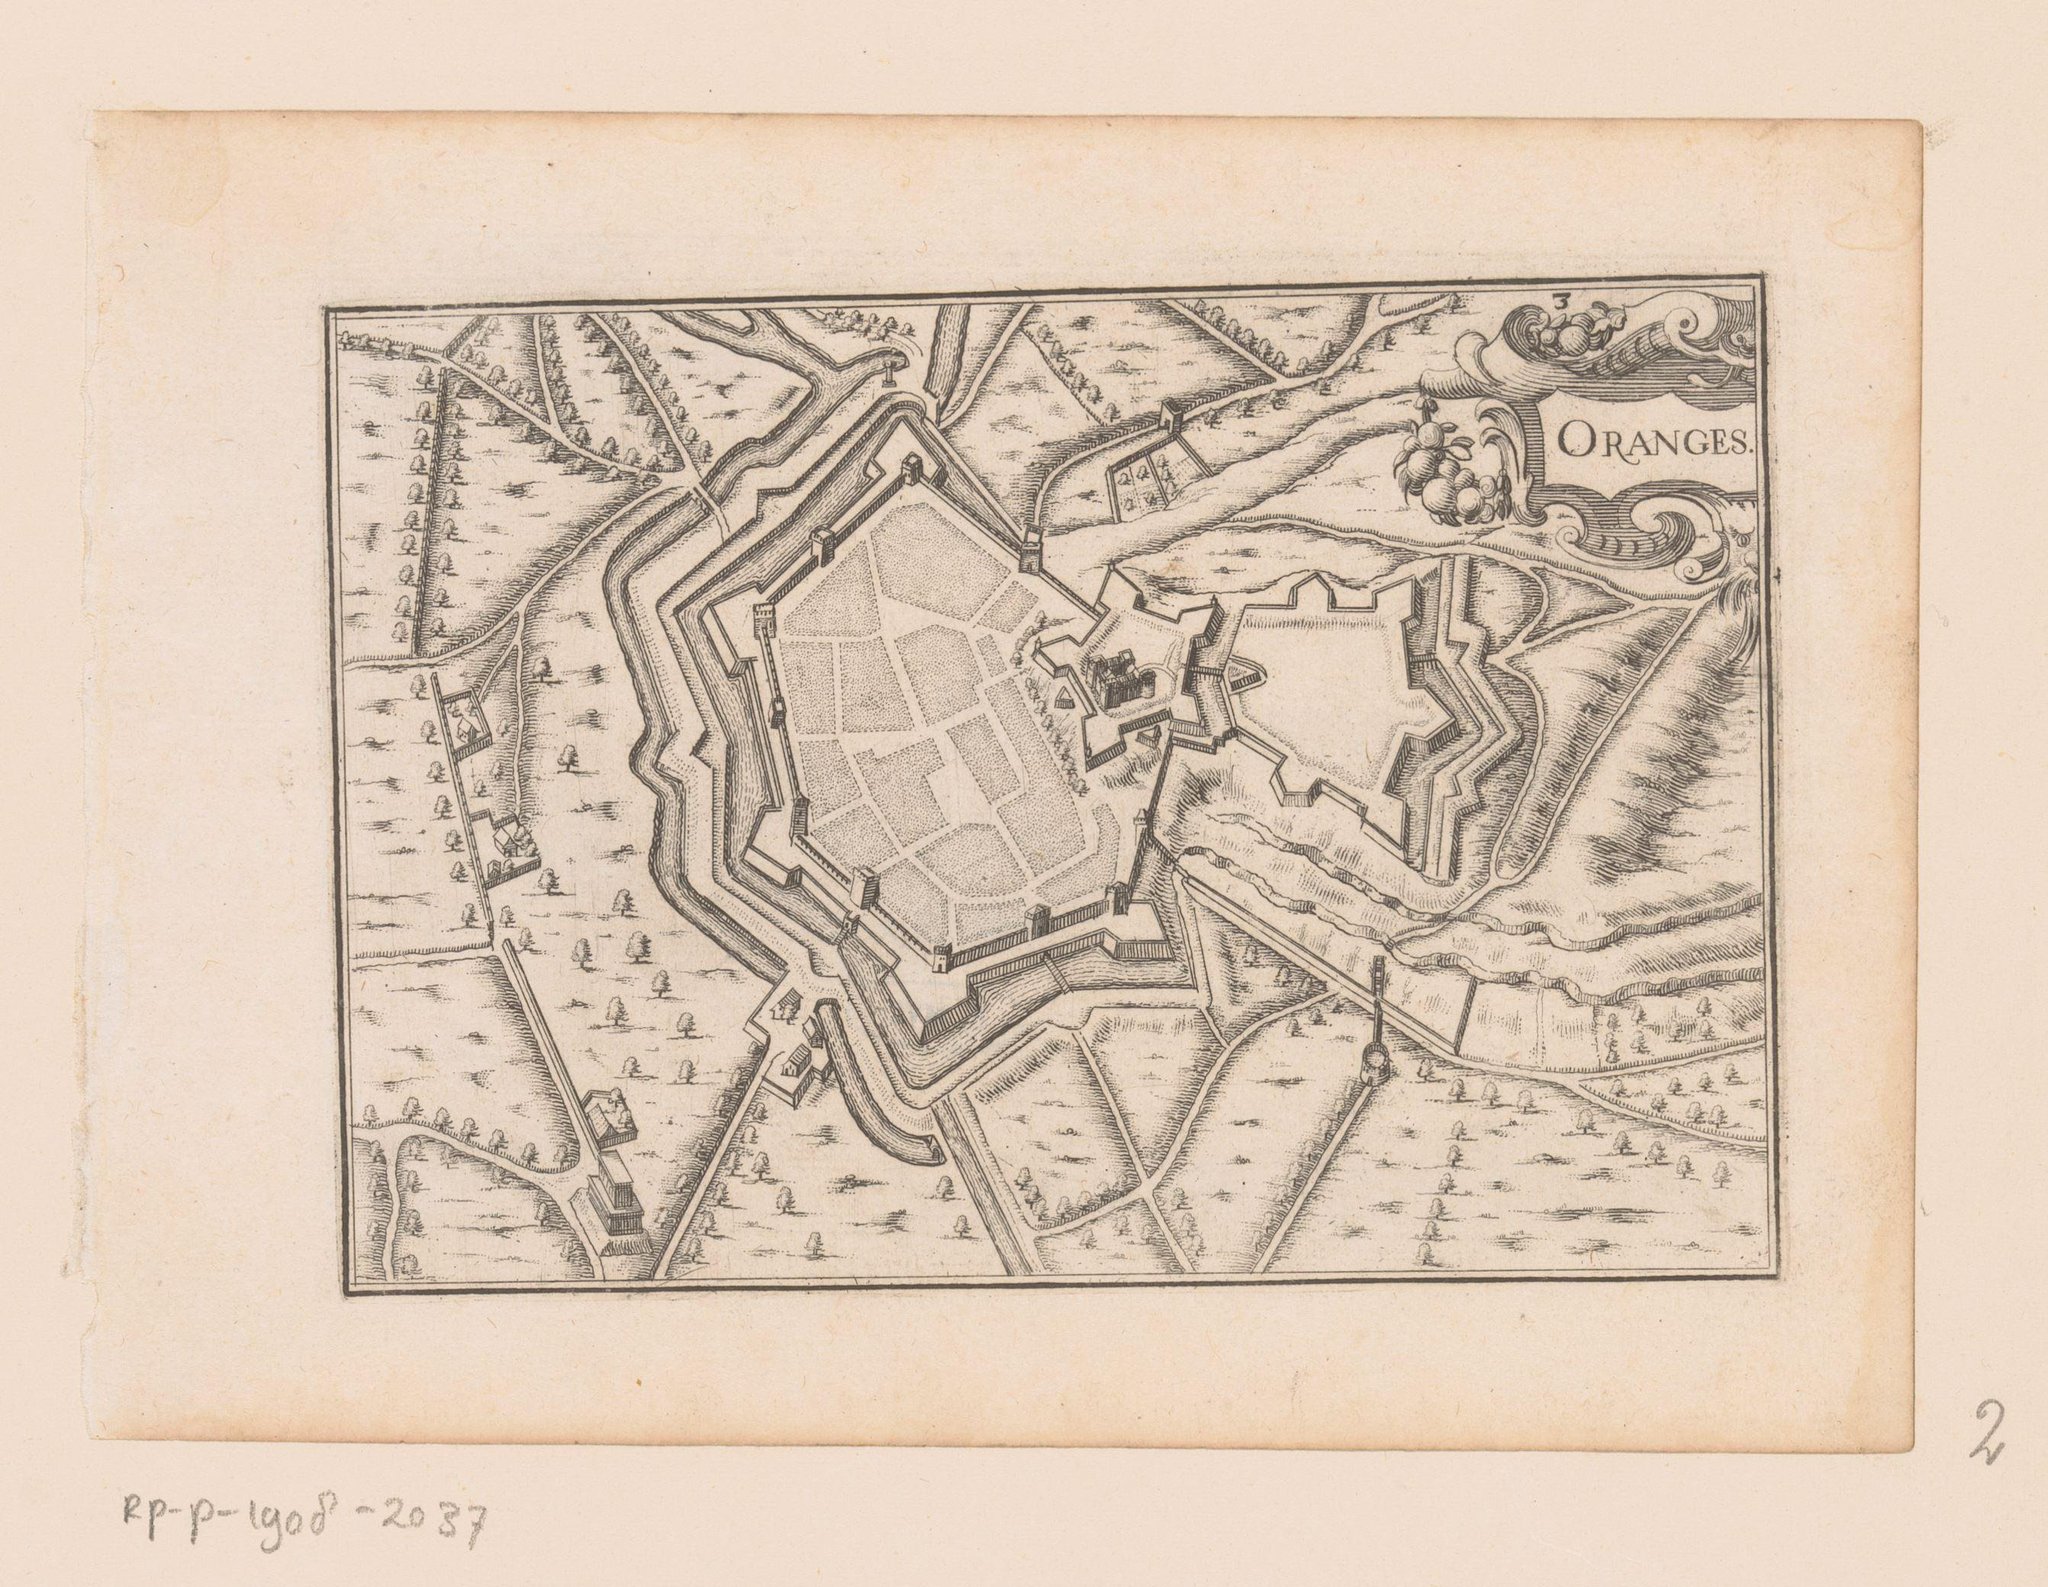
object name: print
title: Vestingplattegrond van Orange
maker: Anonymous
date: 1650-1700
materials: paper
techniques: etching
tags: fortress, fortified city, maps of cities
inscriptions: collector's mark: Lugt 2228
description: Prent maakt mogelijk deel uit van een serie.